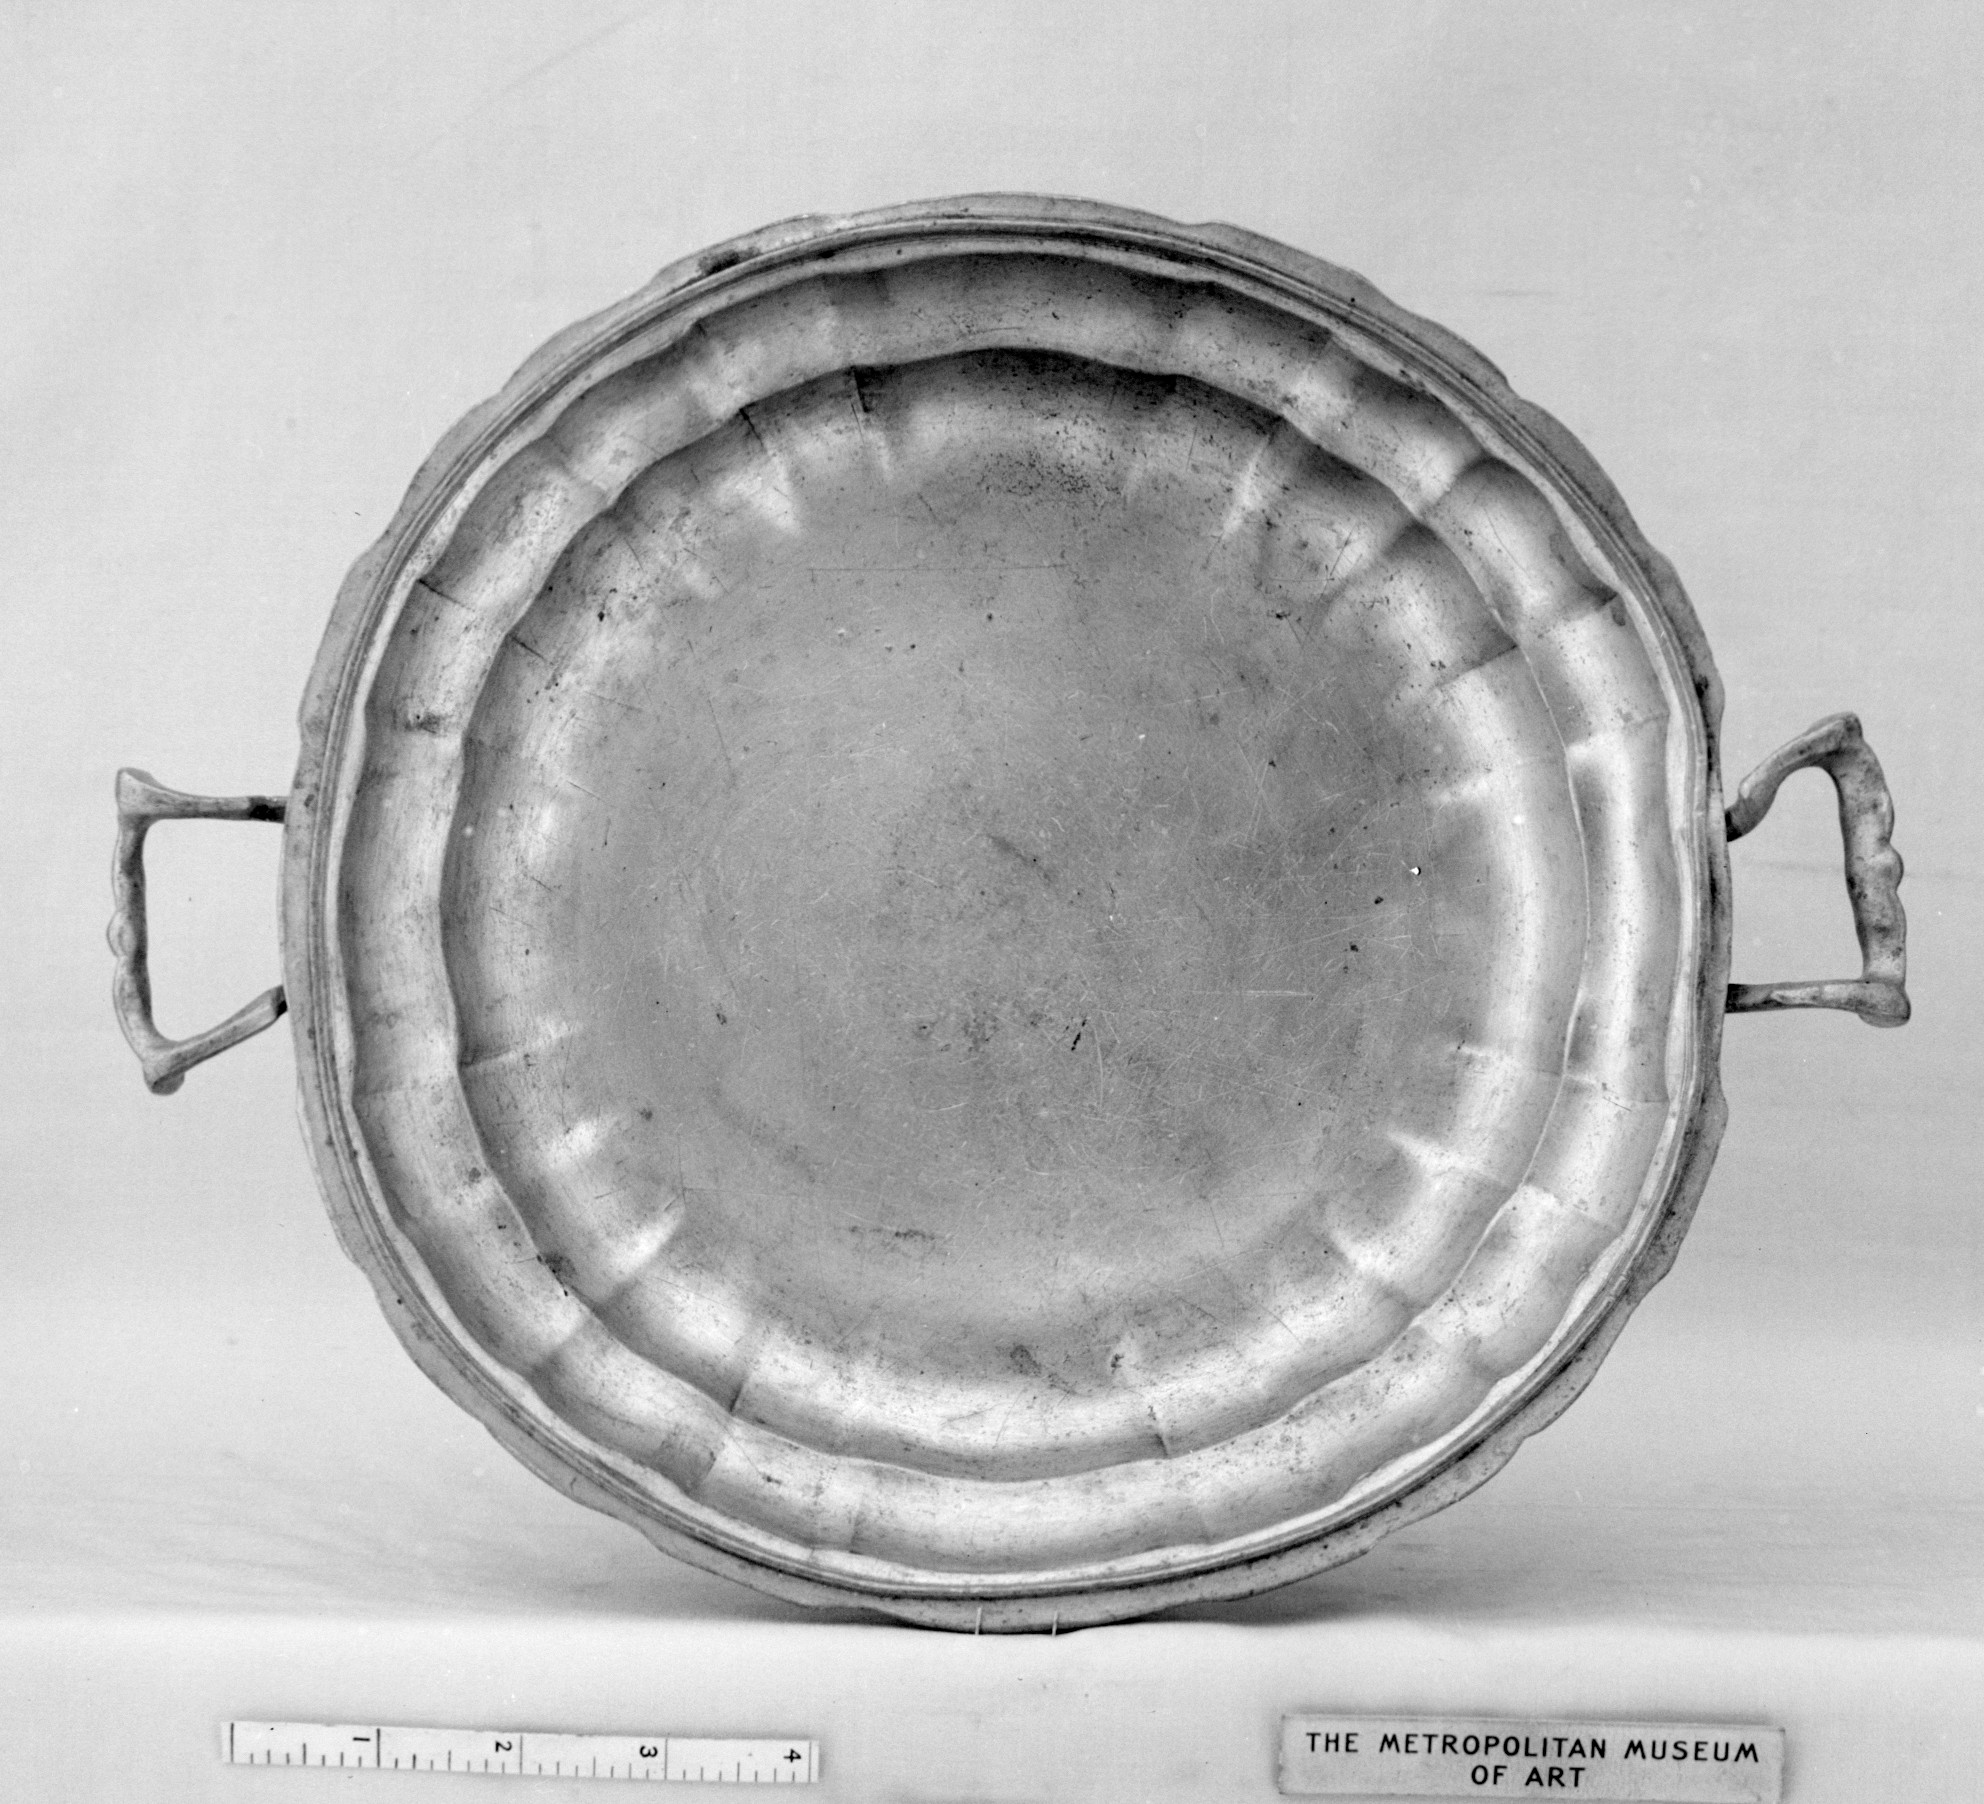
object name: dish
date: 1701-1800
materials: pewter